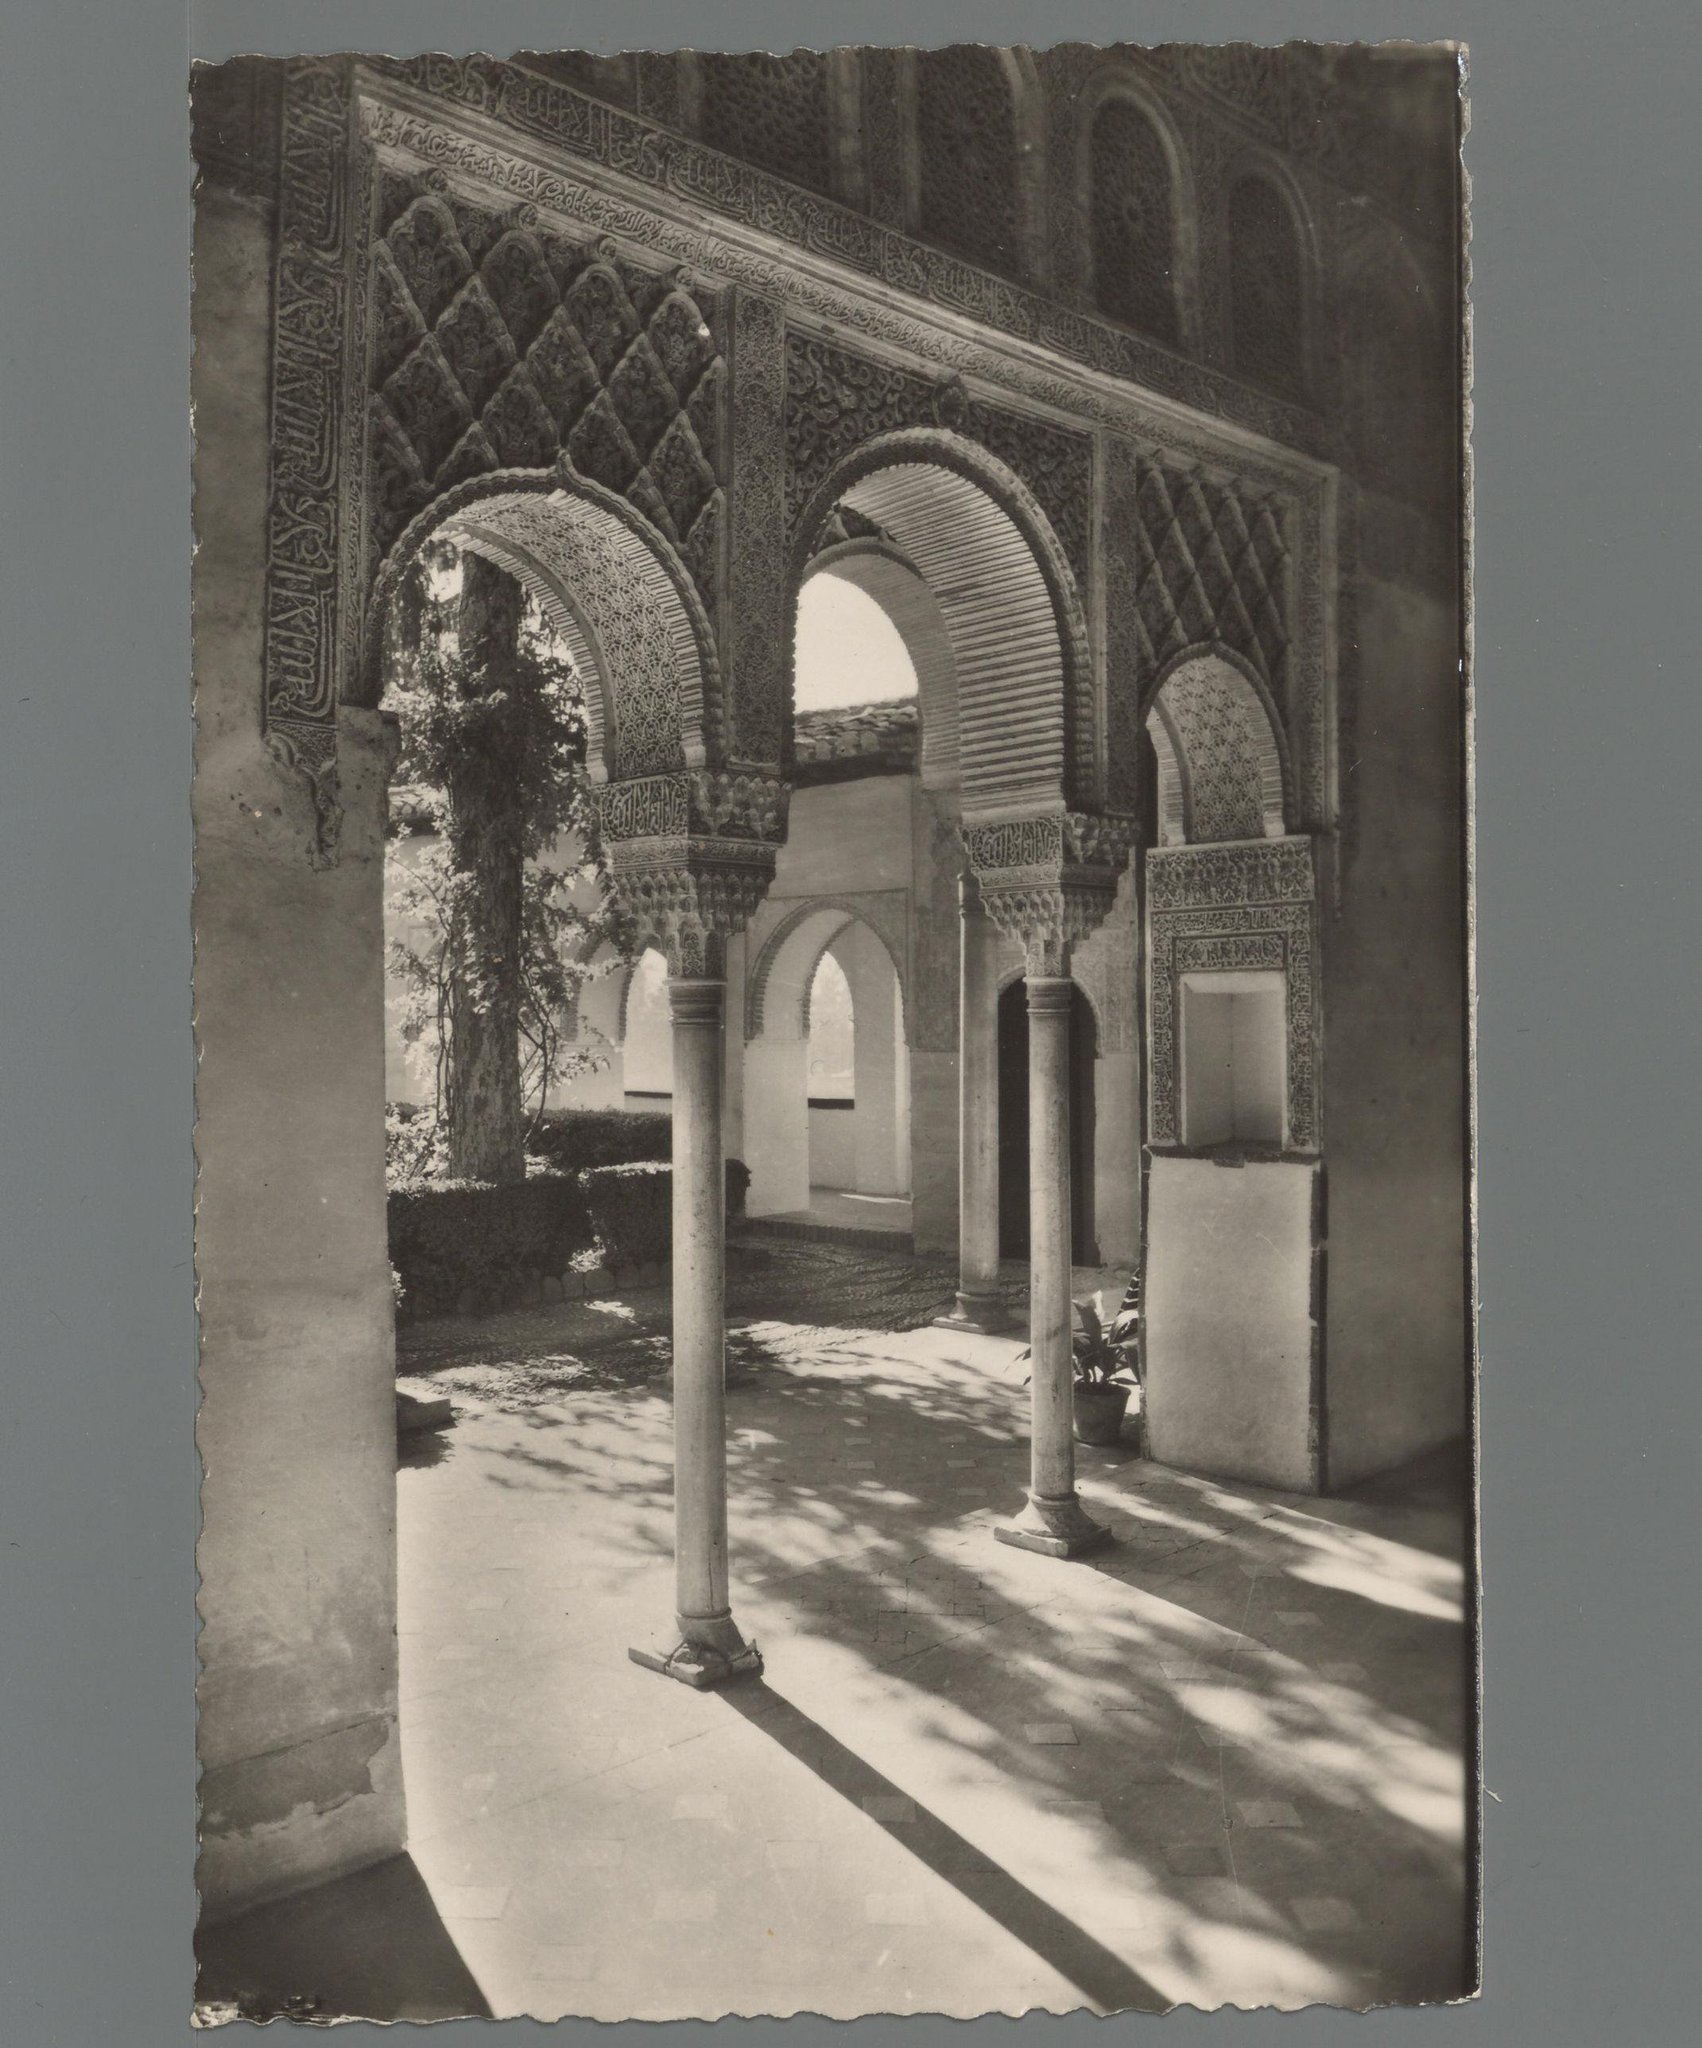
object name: ansichtkaart, prentbriefkaart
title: Granada - Generalife: Interior del Pórtico. Generalife: Interieur du Portique. Generalife: Interior of the Portico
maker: Anonymous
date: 1918-1930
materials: paper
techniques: gelatin silver print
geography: granada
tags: palace